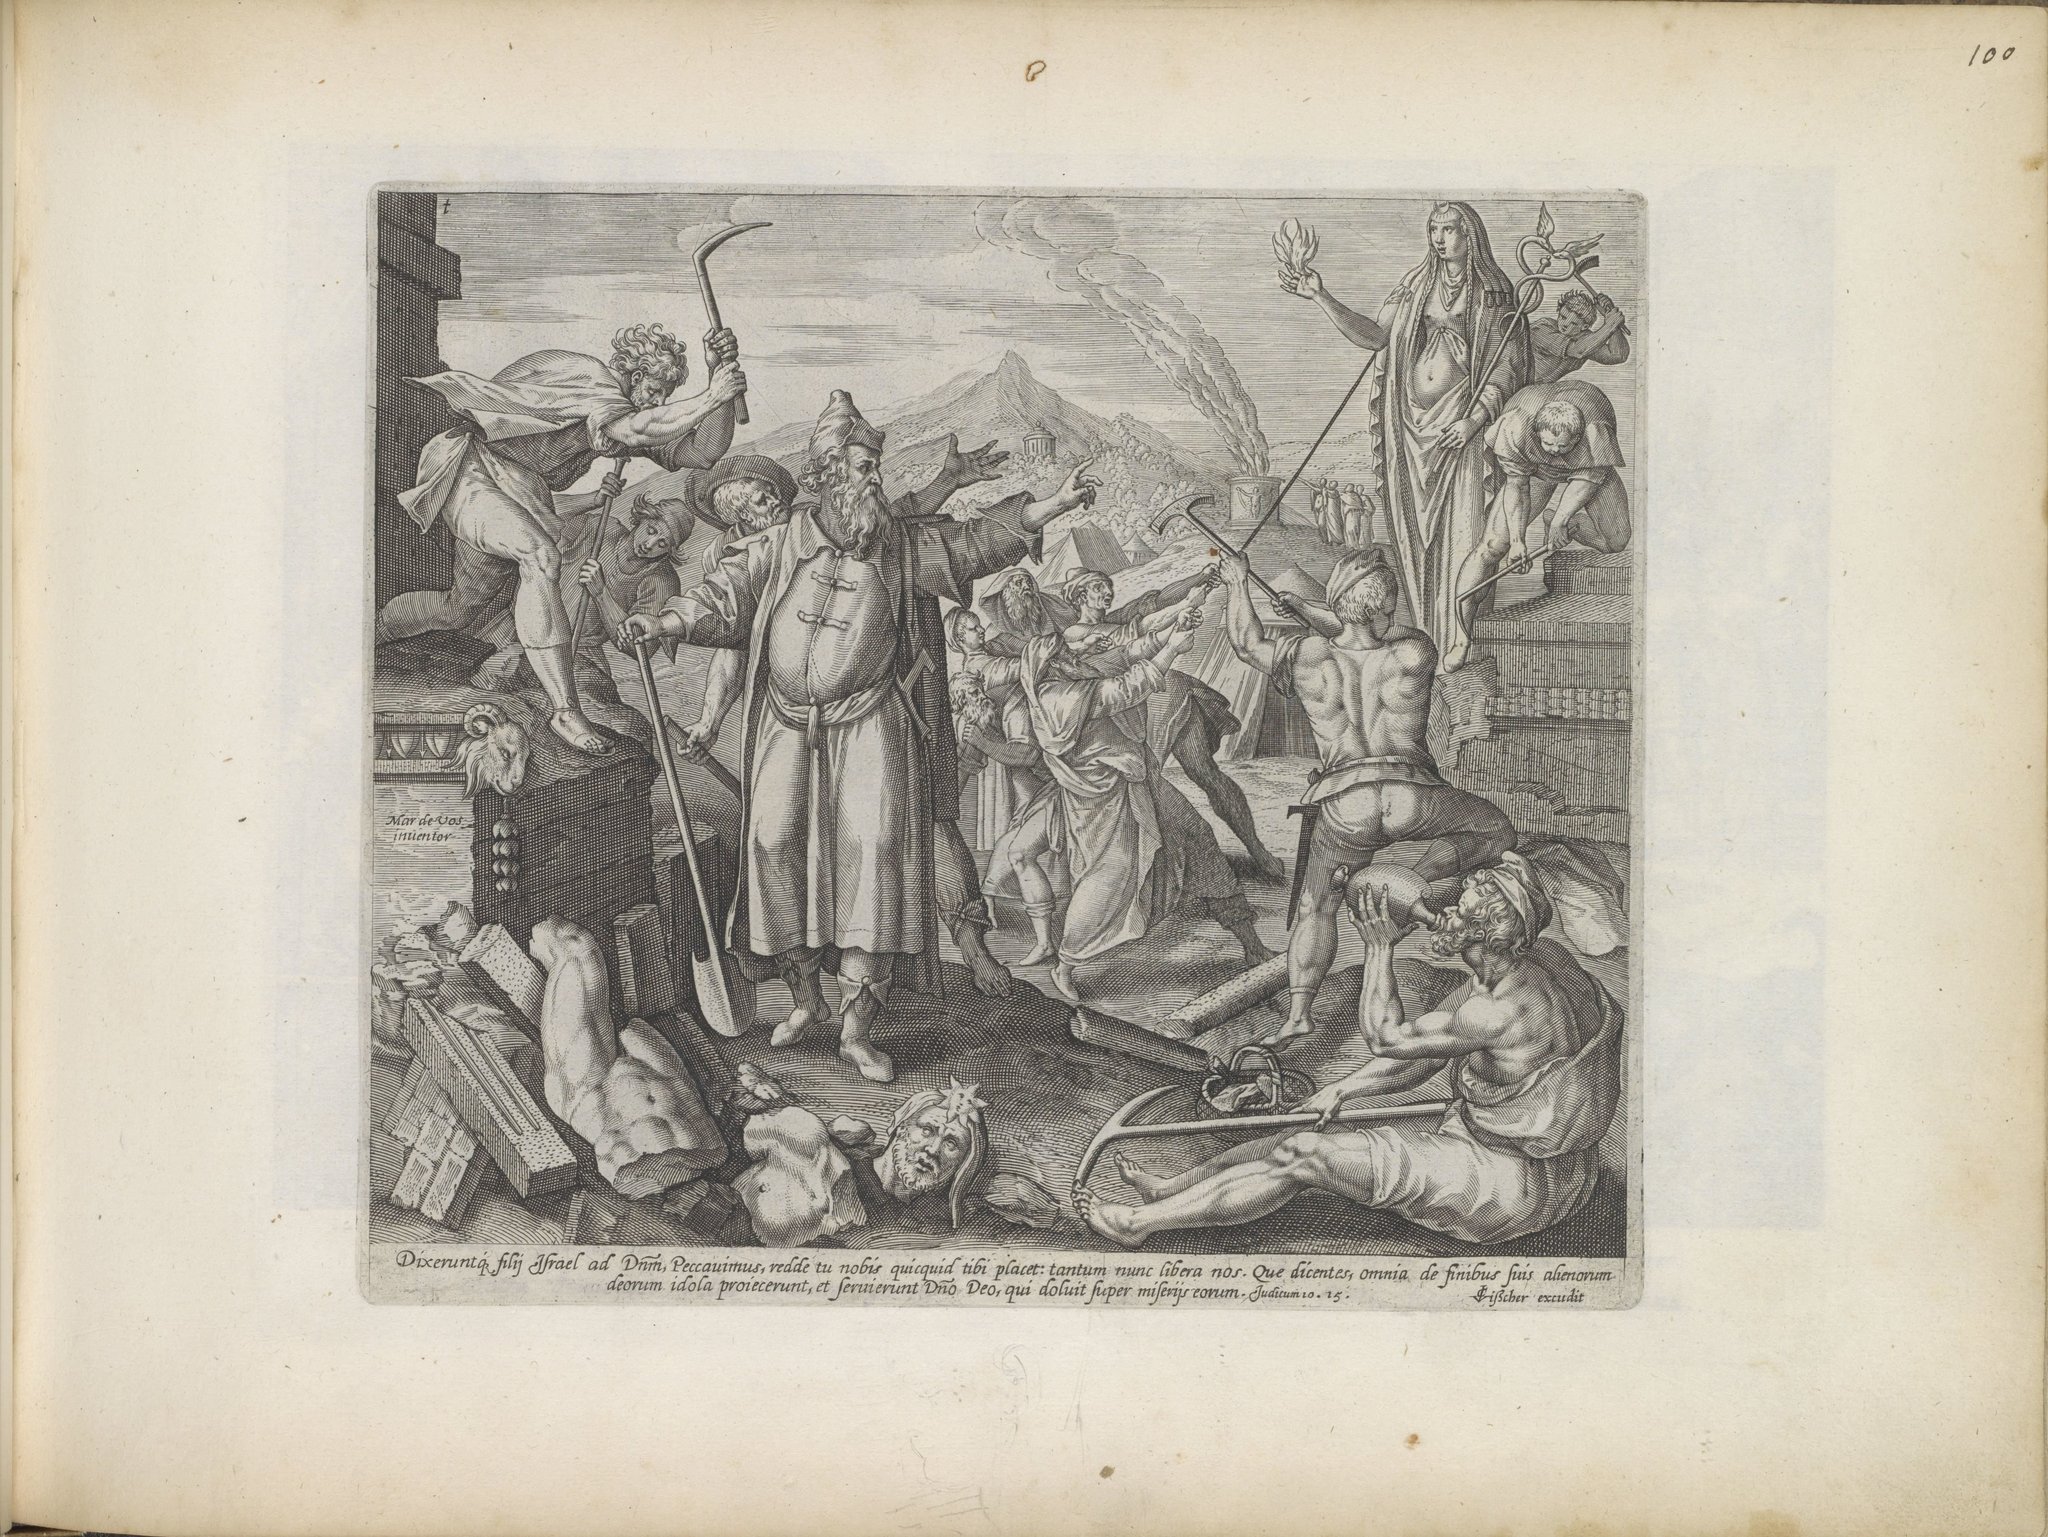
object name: print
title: Theatrum Biblicum Hoc Est Historiae Sacrae Veteris et Novi Testamenti Tabulis Aeneis Expressae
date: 1570-1612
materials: paper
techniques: engraving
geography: amsterdam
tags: the israelites pray the lord to deliver them, israel after jair's death (judges 10:6-18)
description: De Israëlieten vernietigen de afgodsbeelden van Baäl om zo berouw te tonen voor hun zonden ten opzichte van God. Onder de voorstelling een verwijzing in het Latijn naar de Bijbeltekst in Ri. 10:15. Deze prent maakt deel uit van een album.